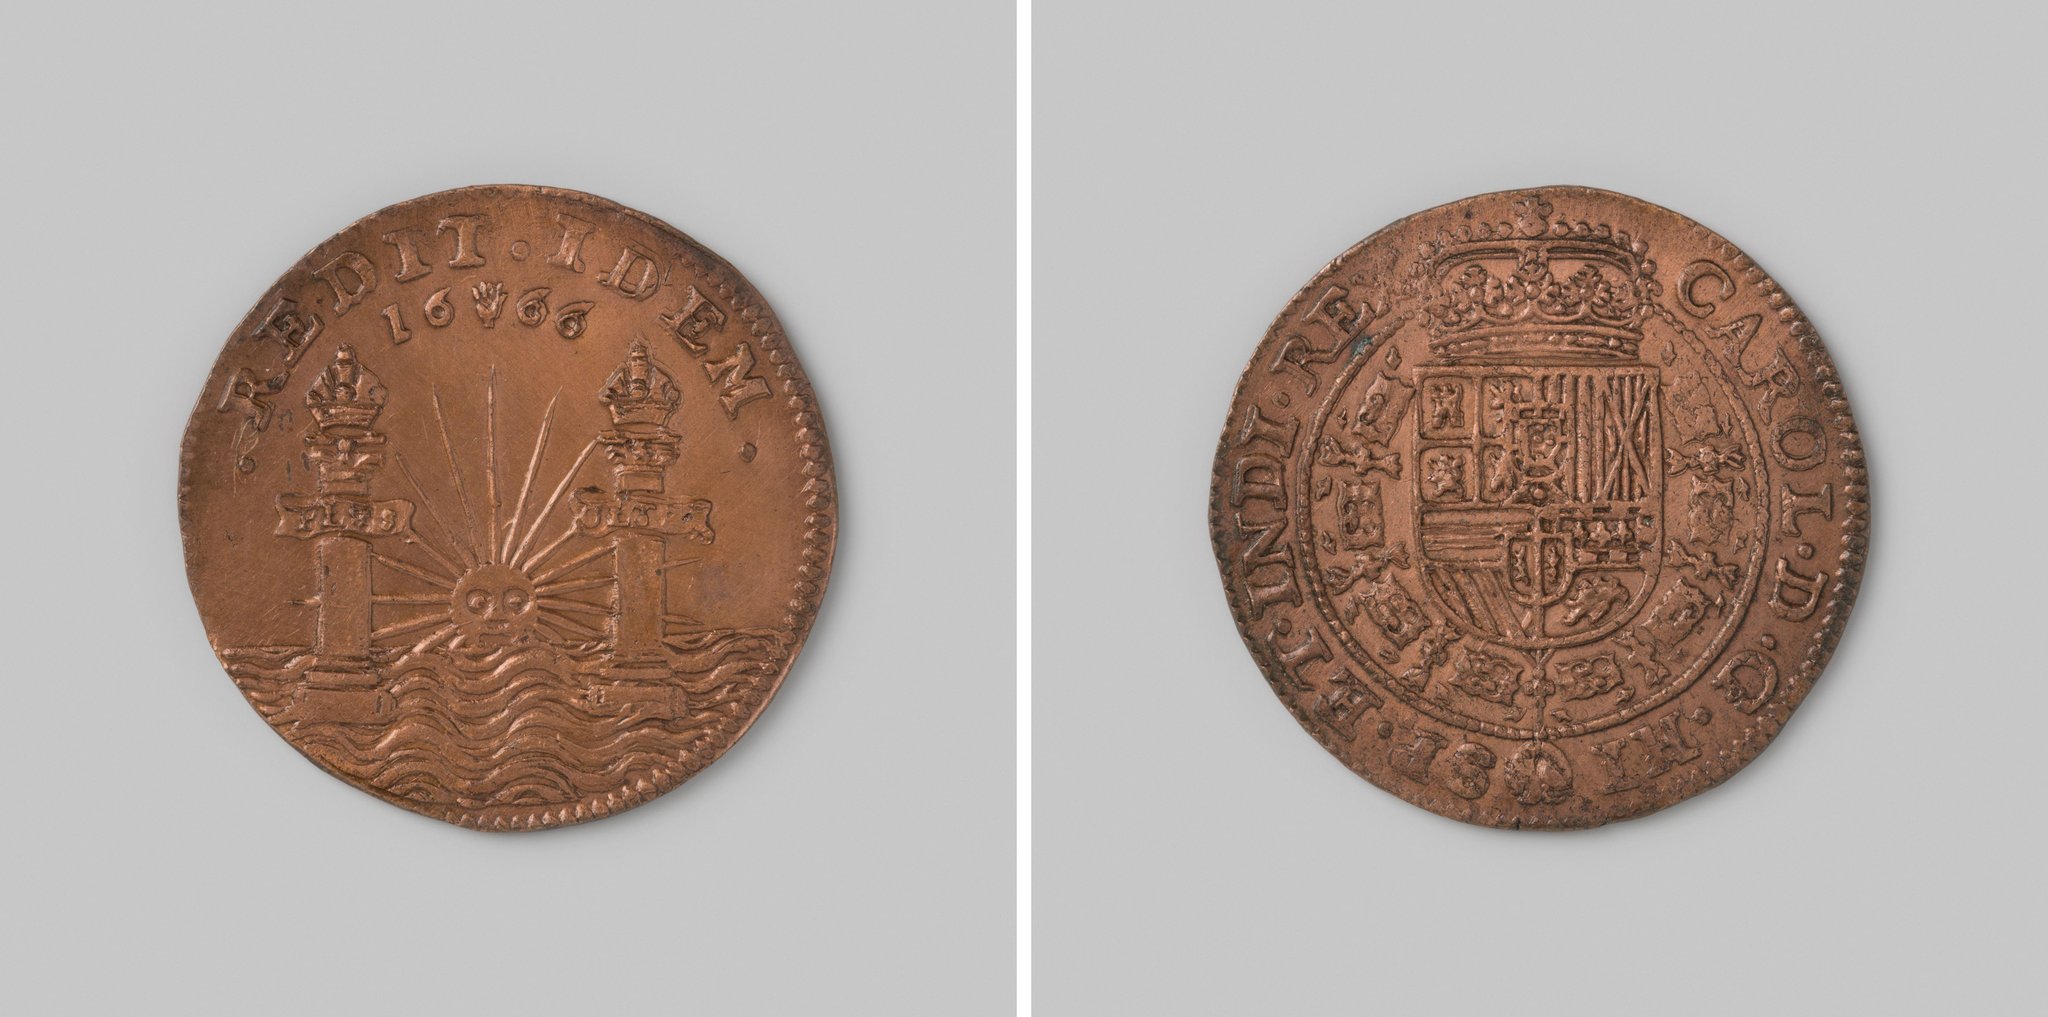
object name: history medal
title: Rekenpenning uit Antwerpen op Koning Karel II van Spanje 1666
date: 1666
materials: copper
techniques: striking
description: Koperen penning, op de voorzijde de zuilen van Hercules met een opkomende zon, met bovenaan dubbel omschrift, op de keerzijde het gekroonde Spaanse wapenschild omhangen met de keten van het gulden vlies, met omschrift.